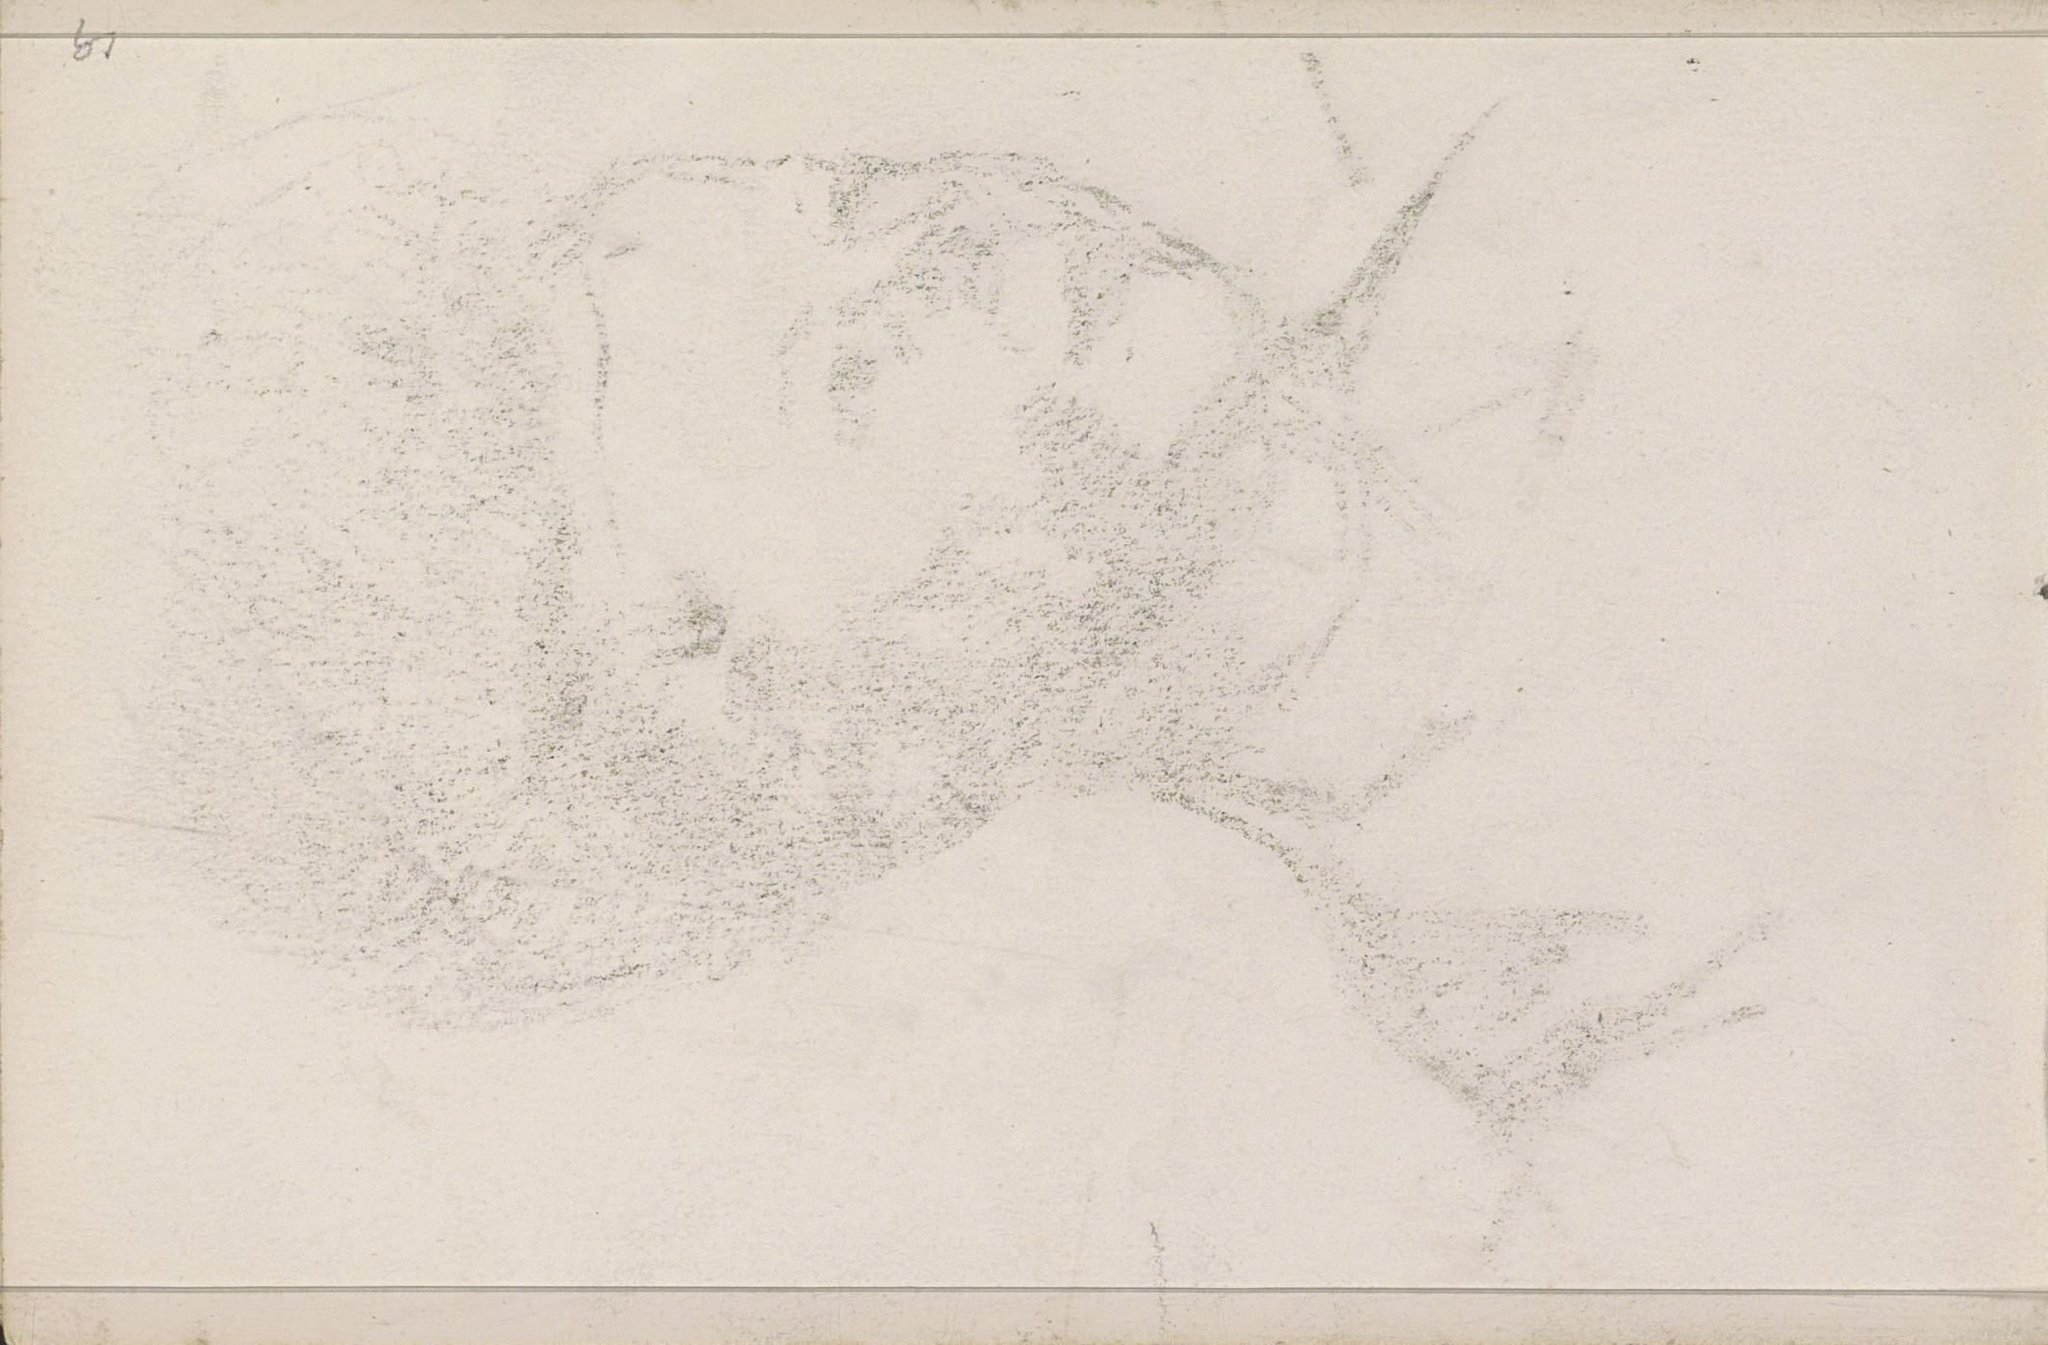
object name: sketchbook leaf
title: Abklatsch van de krijttekening op blad 3 recto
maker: isaac israels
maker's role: draughtsman, painter, print maker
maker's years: 1865-1934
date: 1875-1934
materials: paper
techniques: printmaking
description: Blad 2 verso uit schetsboek LIII met 10 bladen.